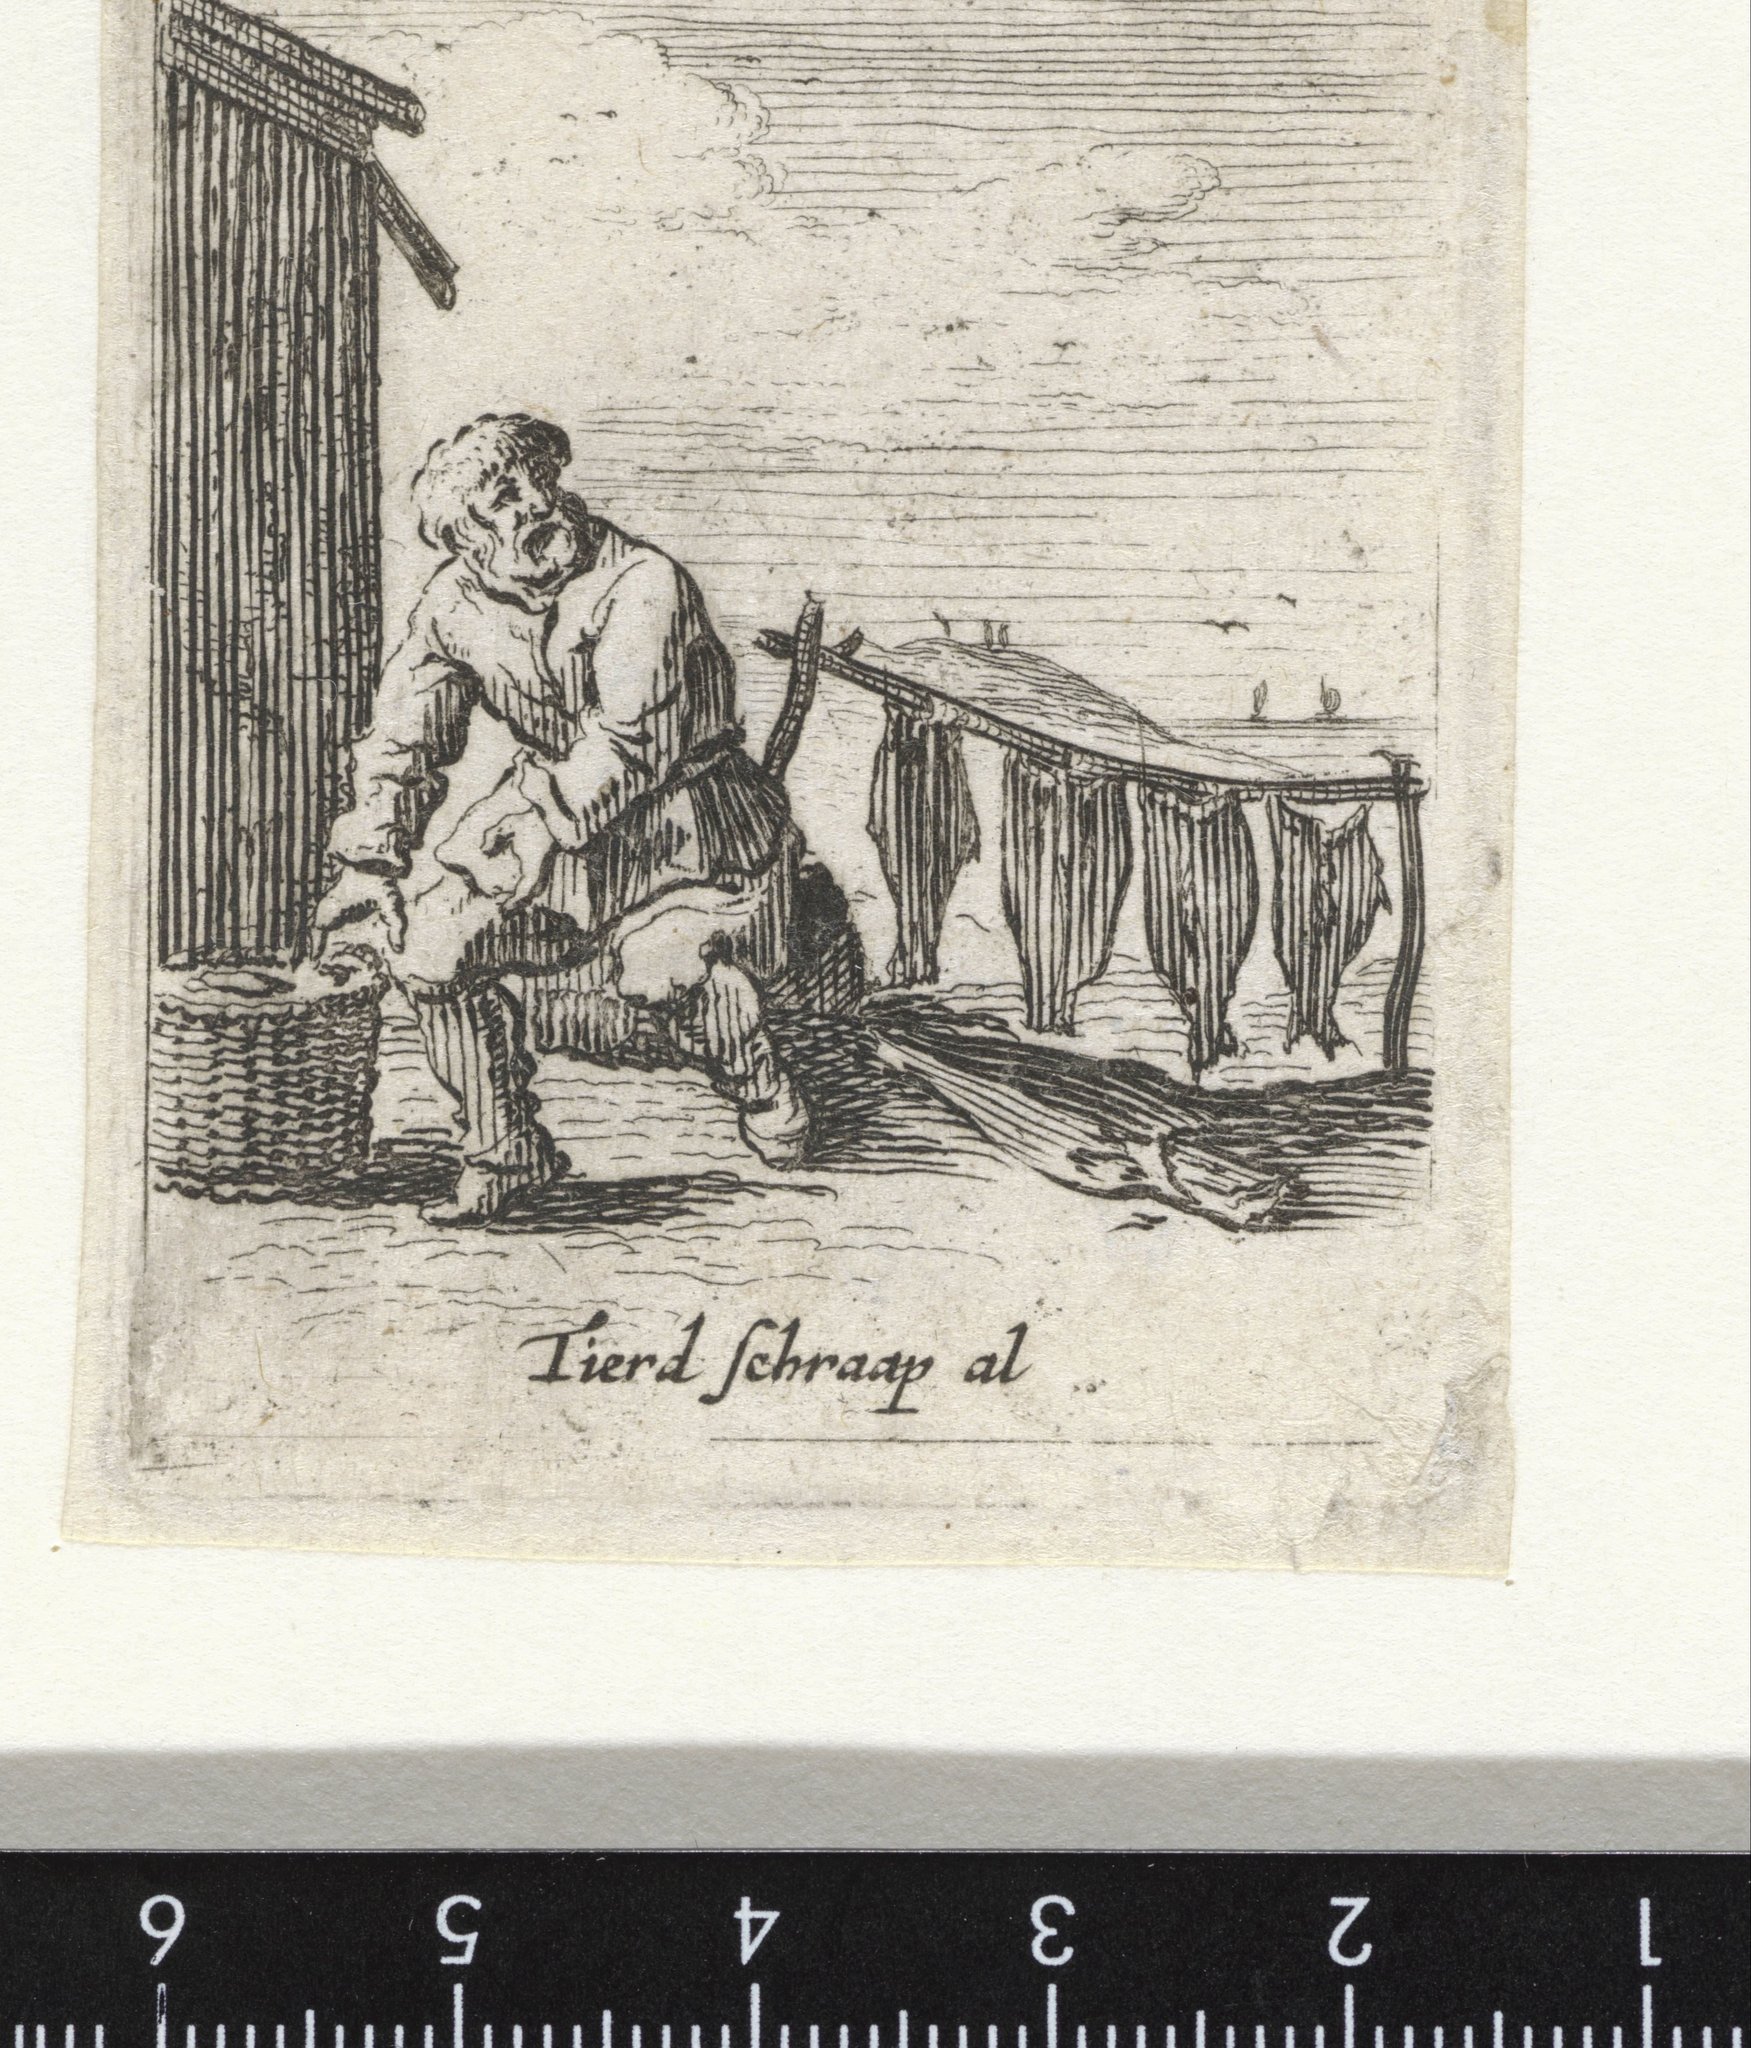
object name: print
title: Visser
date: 1638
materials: paper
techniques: etching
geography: amsterdam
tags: fisherman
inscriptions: collector's mark: Lugt 2228, collector's mark: Lugt 2760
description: Een visser hangt vissen aan een lijn om deze te roken of te drogen. De prent maakt deel uit van een serie van 32 prenten met genretaferelen.